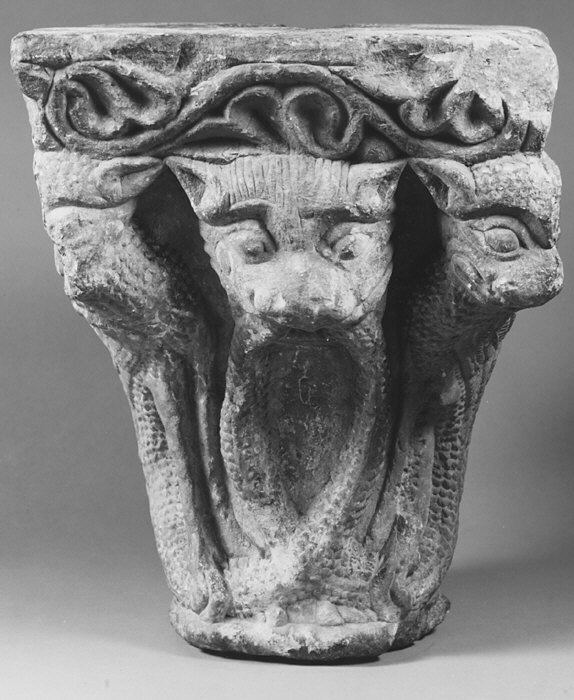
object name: capital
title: Capital with Engaged Impost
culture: south french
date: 1151-1200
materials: limestone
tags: animals